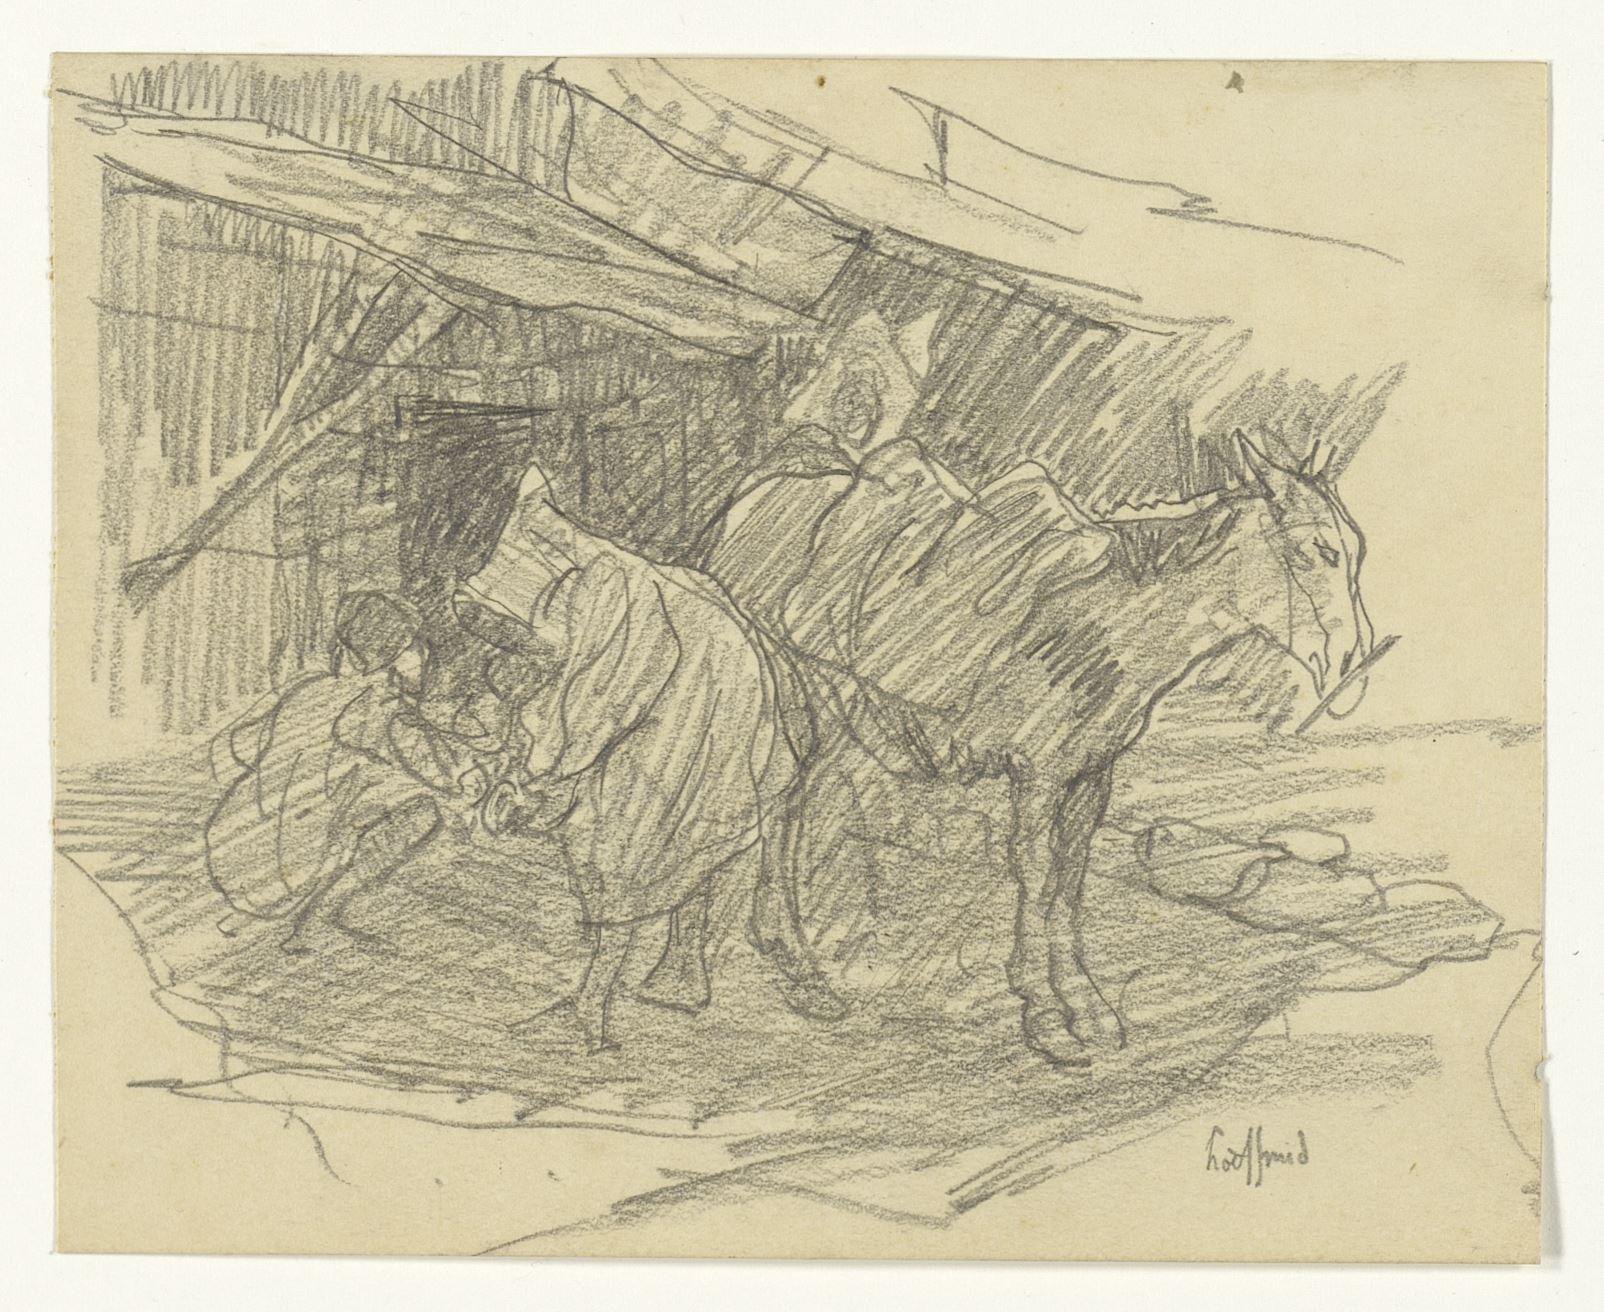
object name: drawing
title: Bij de hoefsmid in Tanger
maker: jac van looij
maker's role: draughtsman, painter, print maker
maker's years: 1855-1930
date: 1902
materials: paper, pencil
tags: ass, donkey, smith, blacksmith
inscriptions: inscription: ‘hoefsmid’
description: De huidige titel is door het Rijksmuseum overgenomen van het Instituut Collectie Nederland.